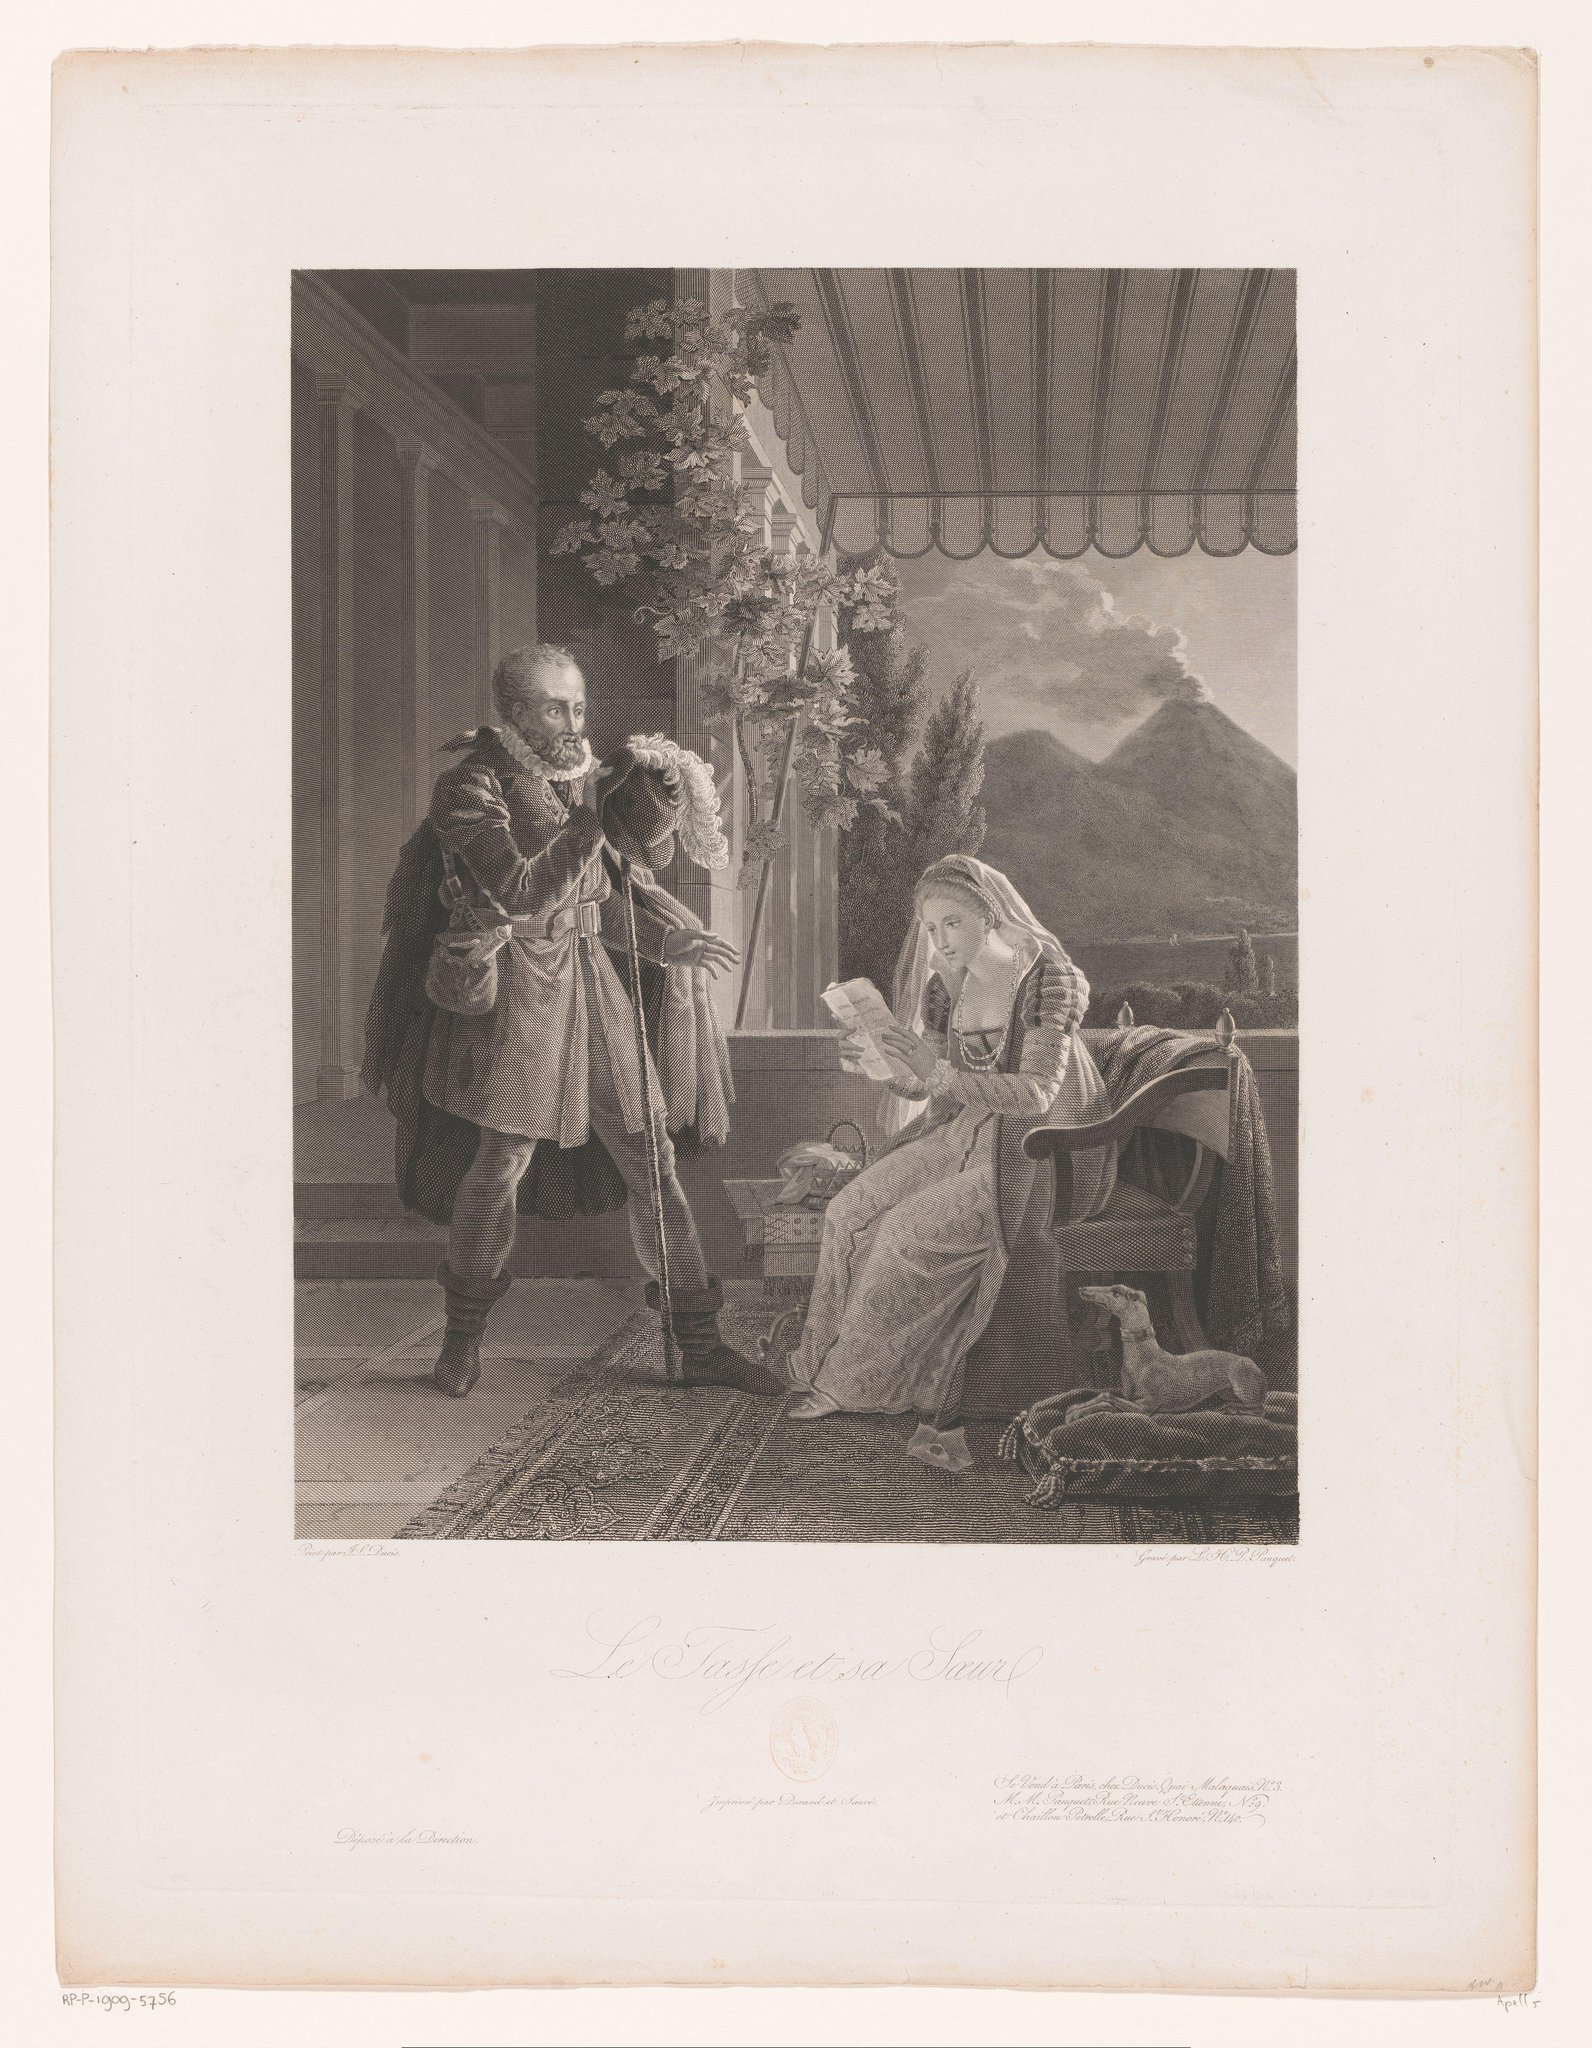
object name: print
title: Torquato Tasso en brieflezende vrouw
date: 1807-1831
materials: paper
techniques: engraving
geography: paris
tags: torquato tasso, reading, historical persons, letter, envelope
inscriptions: collector's mark: Lugt 2228, : ‘Déposé à la Direction’, collector's mark: Lugt 6165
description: De vrouw is mogelijk prinses Eleonore of, volgens het onderschrift, de zus van Tasso.